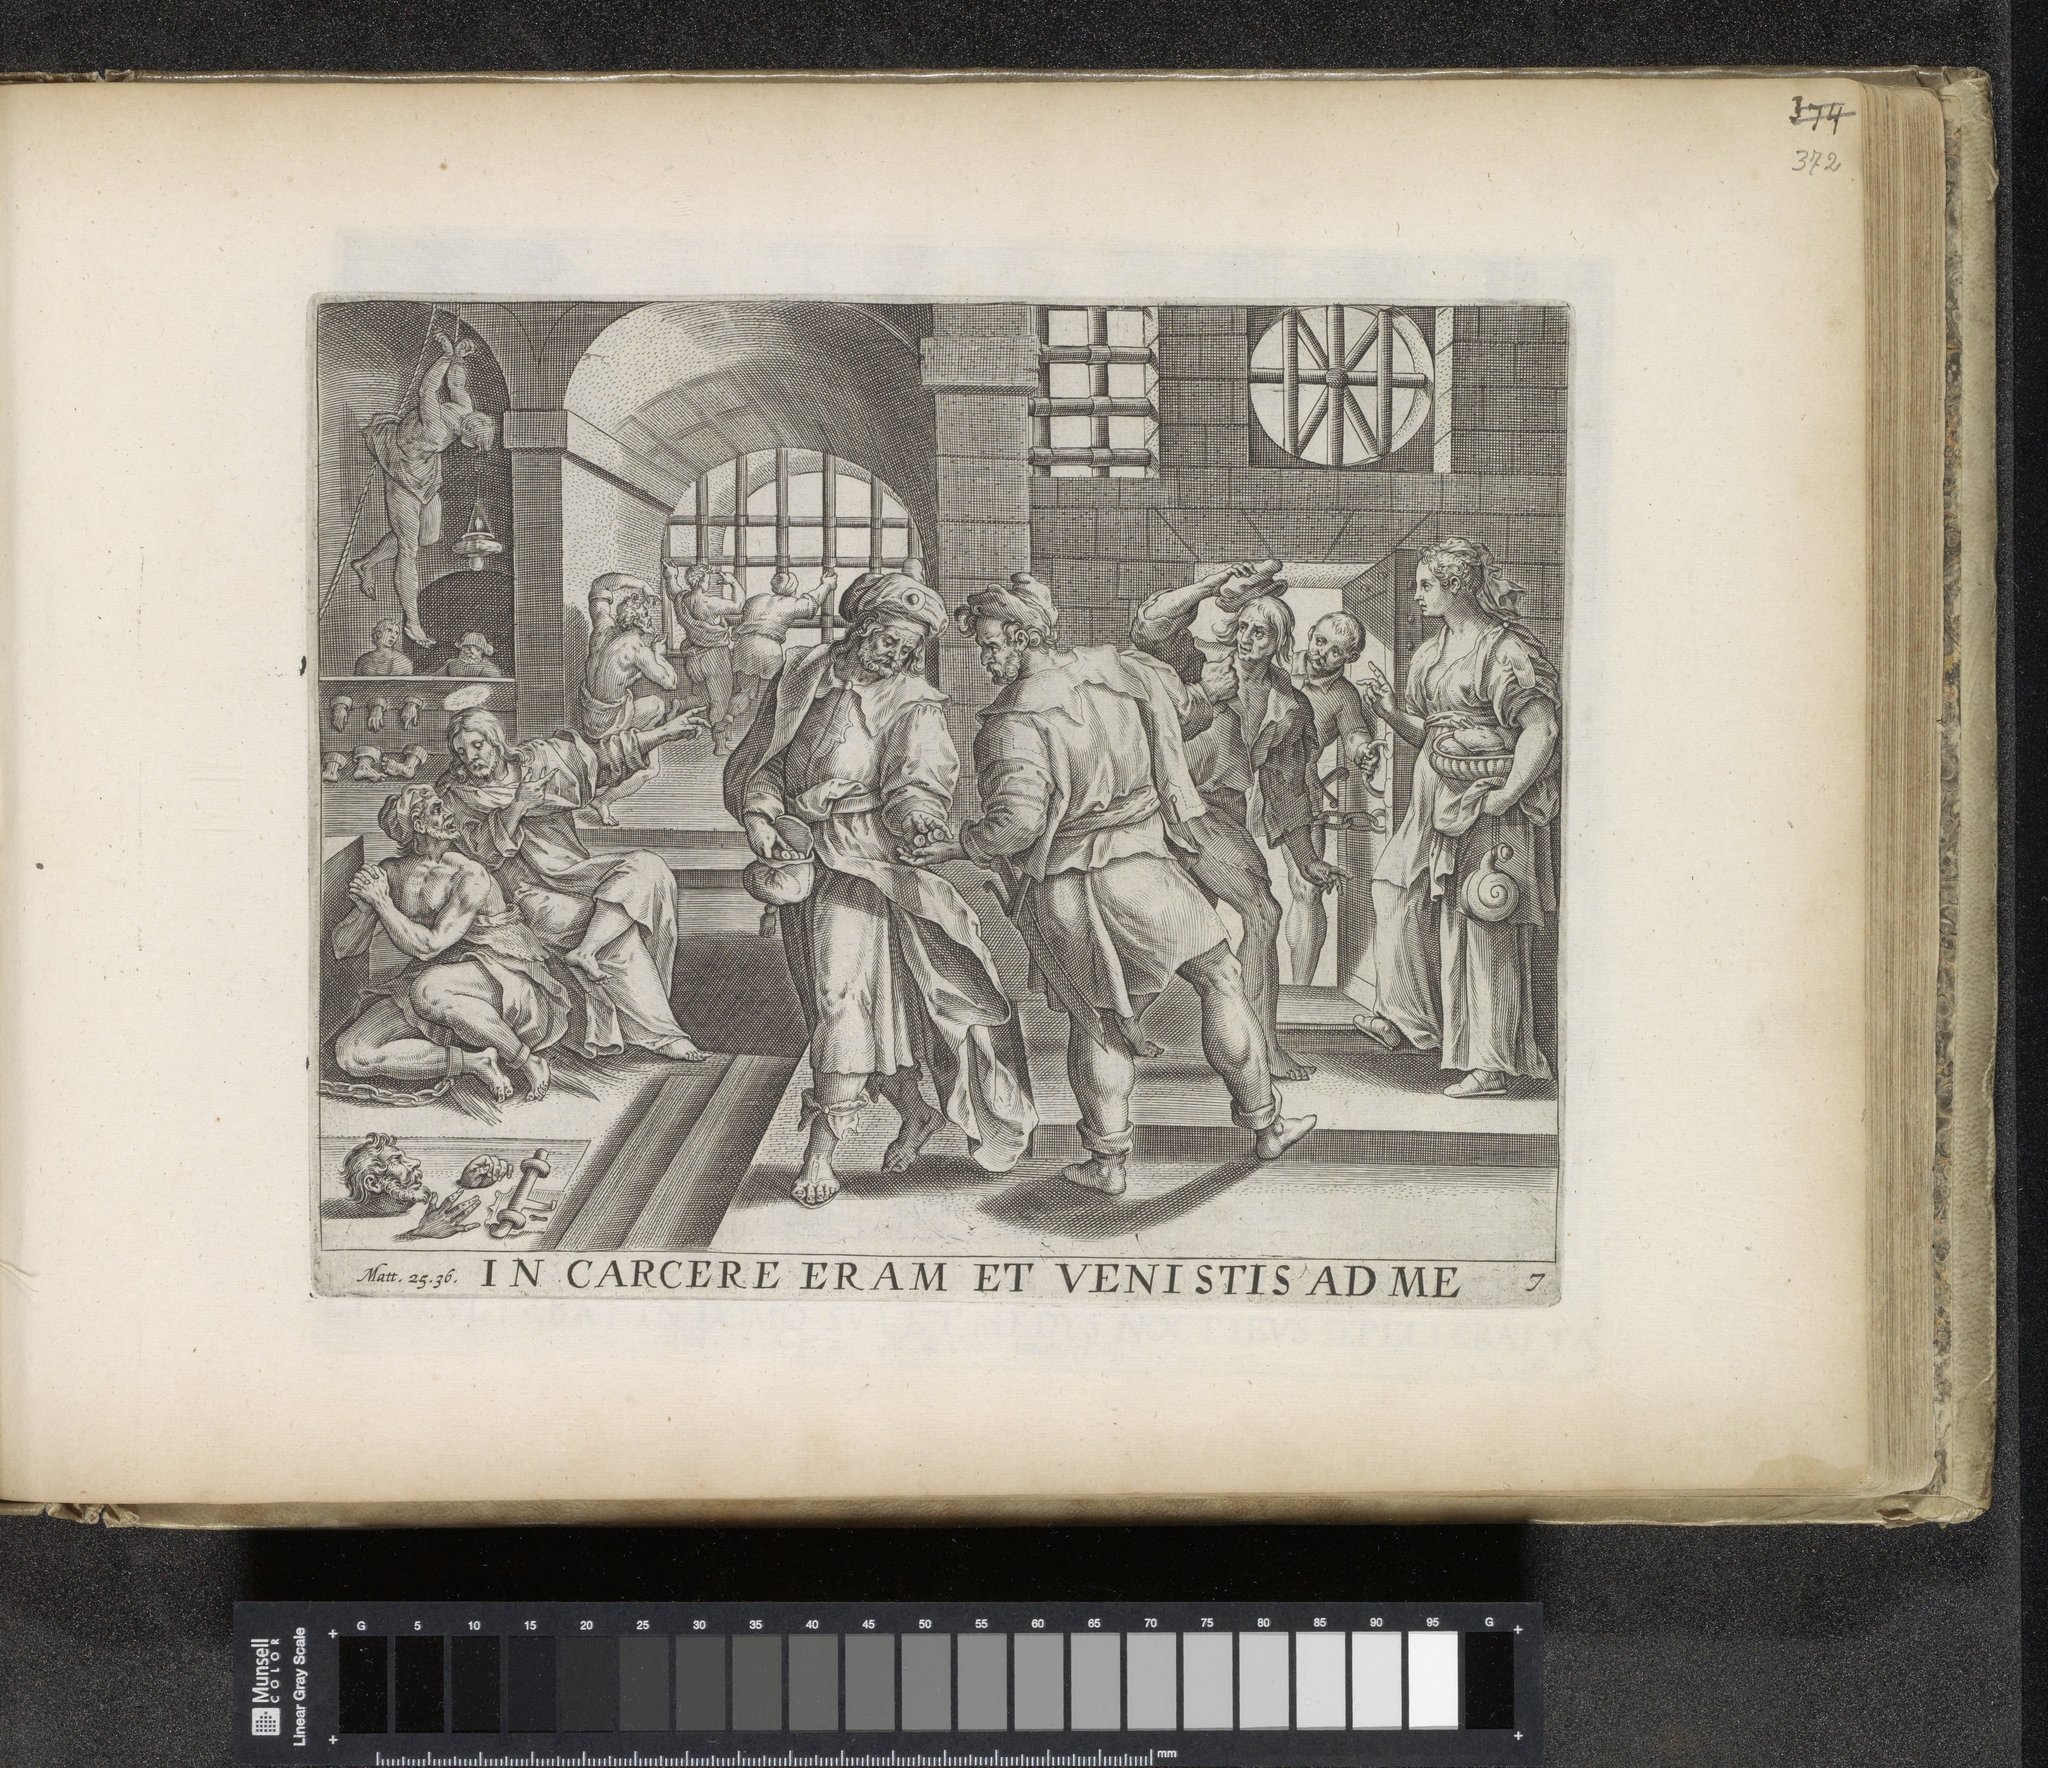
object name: album leaf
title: Zeven werken van barmhartigheid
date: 1585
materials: paper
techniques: engraving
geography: amsterdam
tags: visiting or liberating the imprisoned, 'incarceratus solatur' ~ one of the (seven) acts of mercy - vv - christ present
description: Verschillende mensen bezoeken de gevangenen in de gevangenis. Een man koopt een gevangene vrij. Een vrouw brengt voedsel. Christus spreekt links met een gevangene en wijst hem op de deur. Onder de voorstelling een verwijzing in het Latijn naar de Bijbeltekst in Mat. 25:36. Deze prent maakt deel uit van een album.